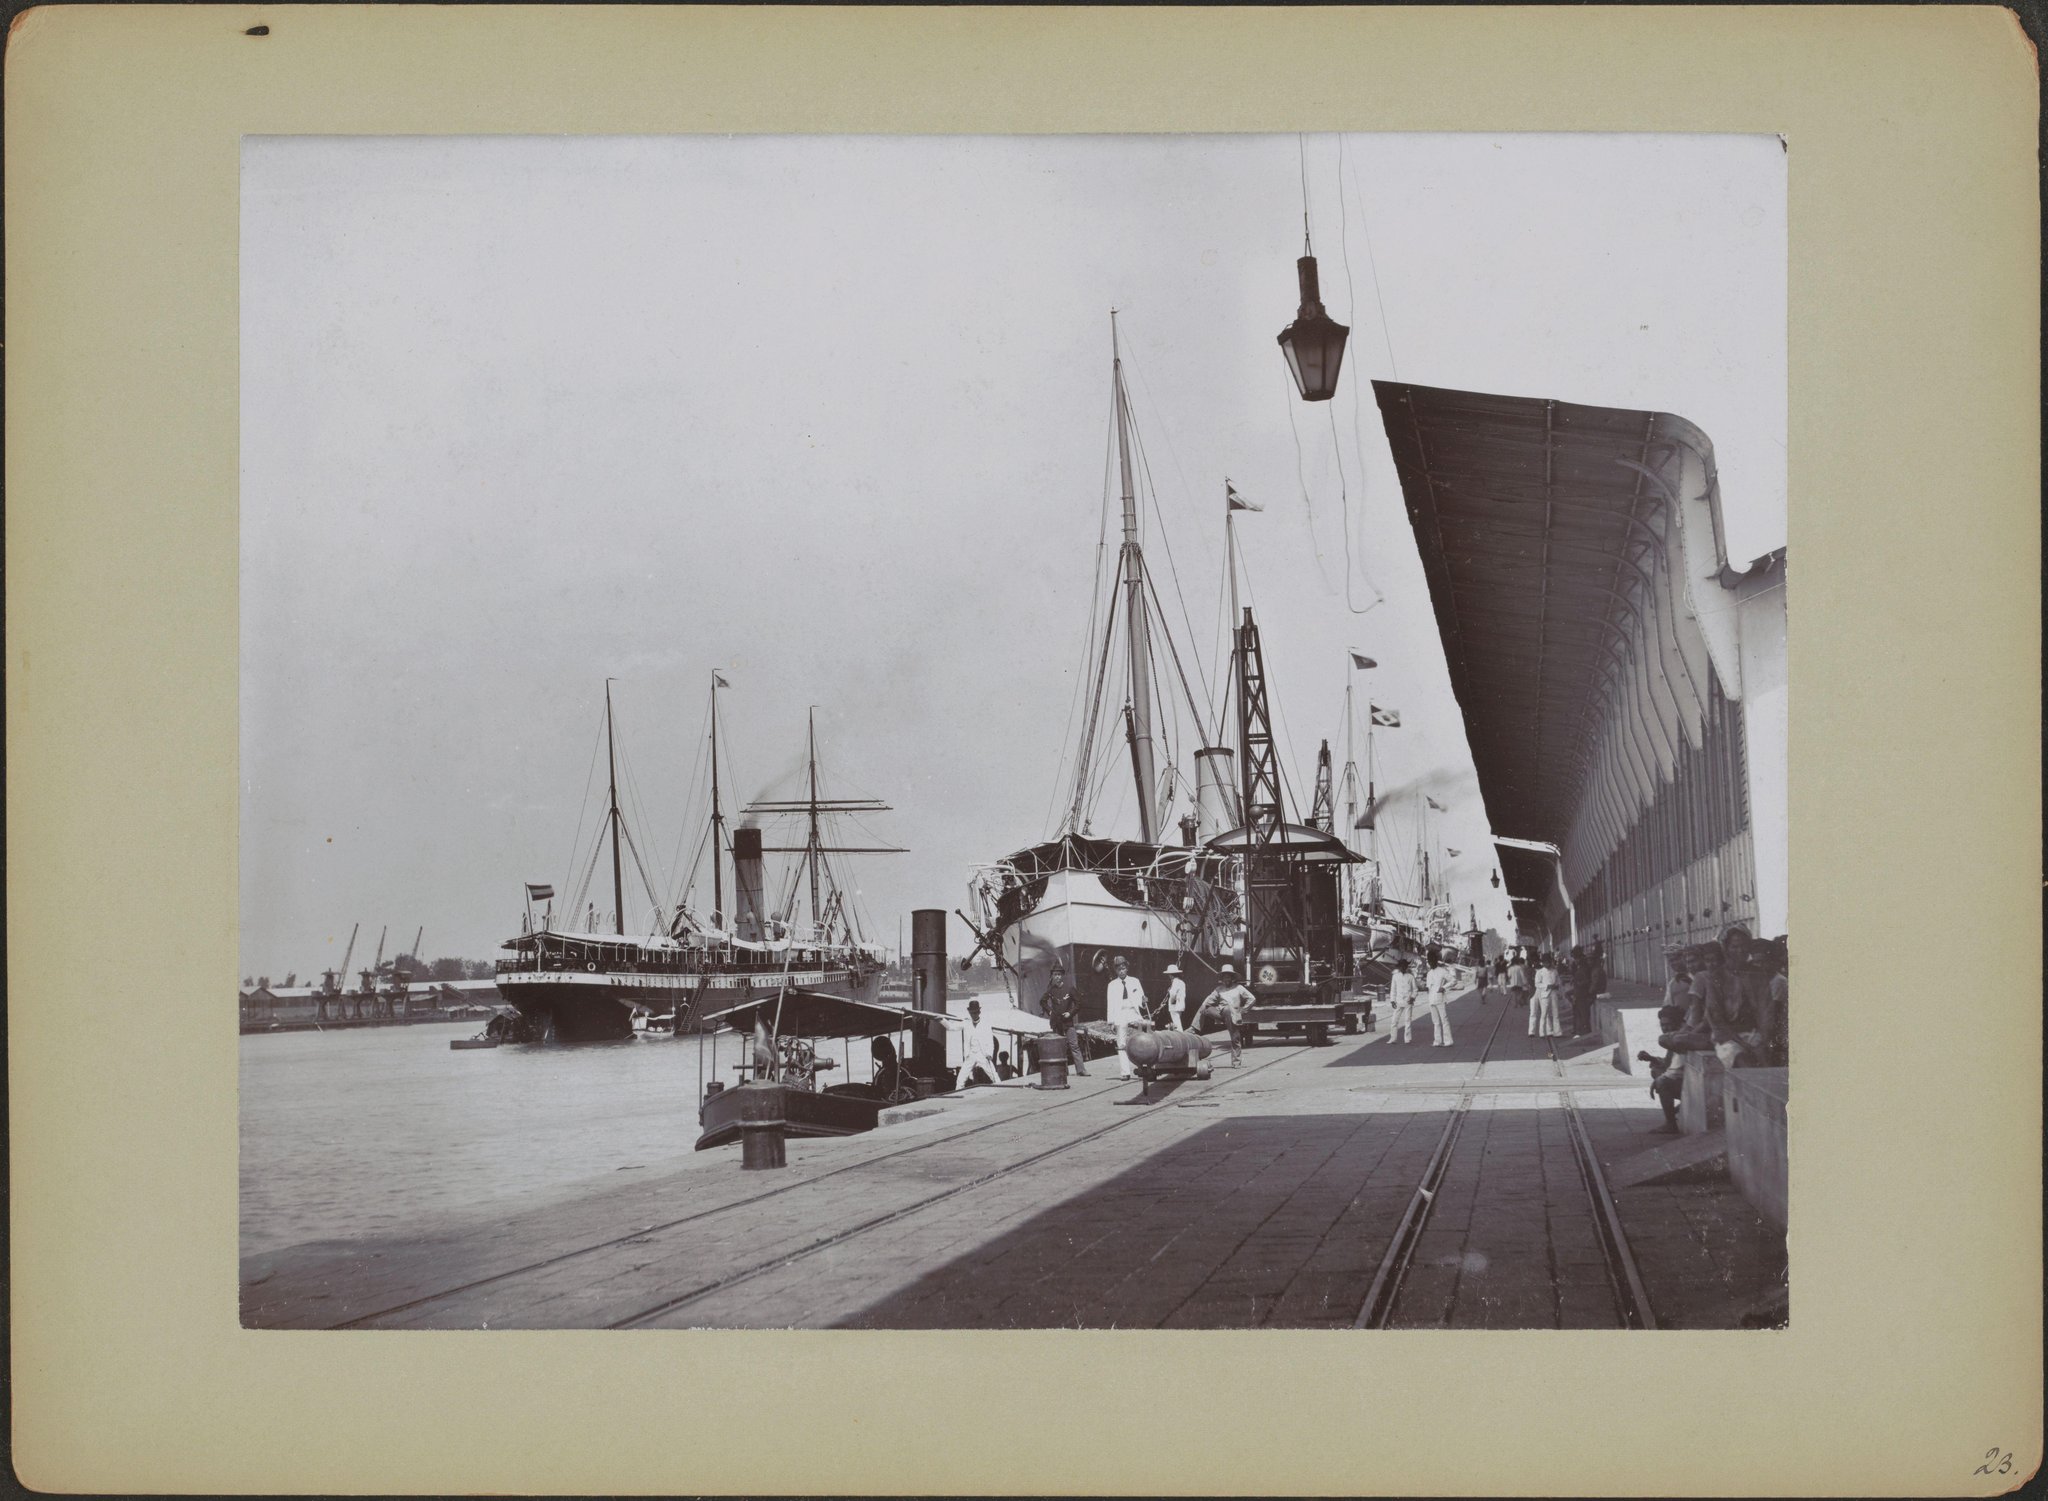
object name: photograph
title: Schepen aan de kade van Tandjong Priok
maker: Anonymous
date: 1870-1910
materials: cardboard, paper, photographic support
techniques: collodion silver print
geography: tanjung priok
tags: harbour (+ view ~ vehicle, ship, etc.)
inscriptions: inscription: ‘Tandjong Priok. Haven van Batavia’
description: Onderdeel van Reisalbum met foto's van bezienswaardigheden in Marseille, Port Said, Aden, Bombay, Colombo, Singapore en Nederlands-Indië.